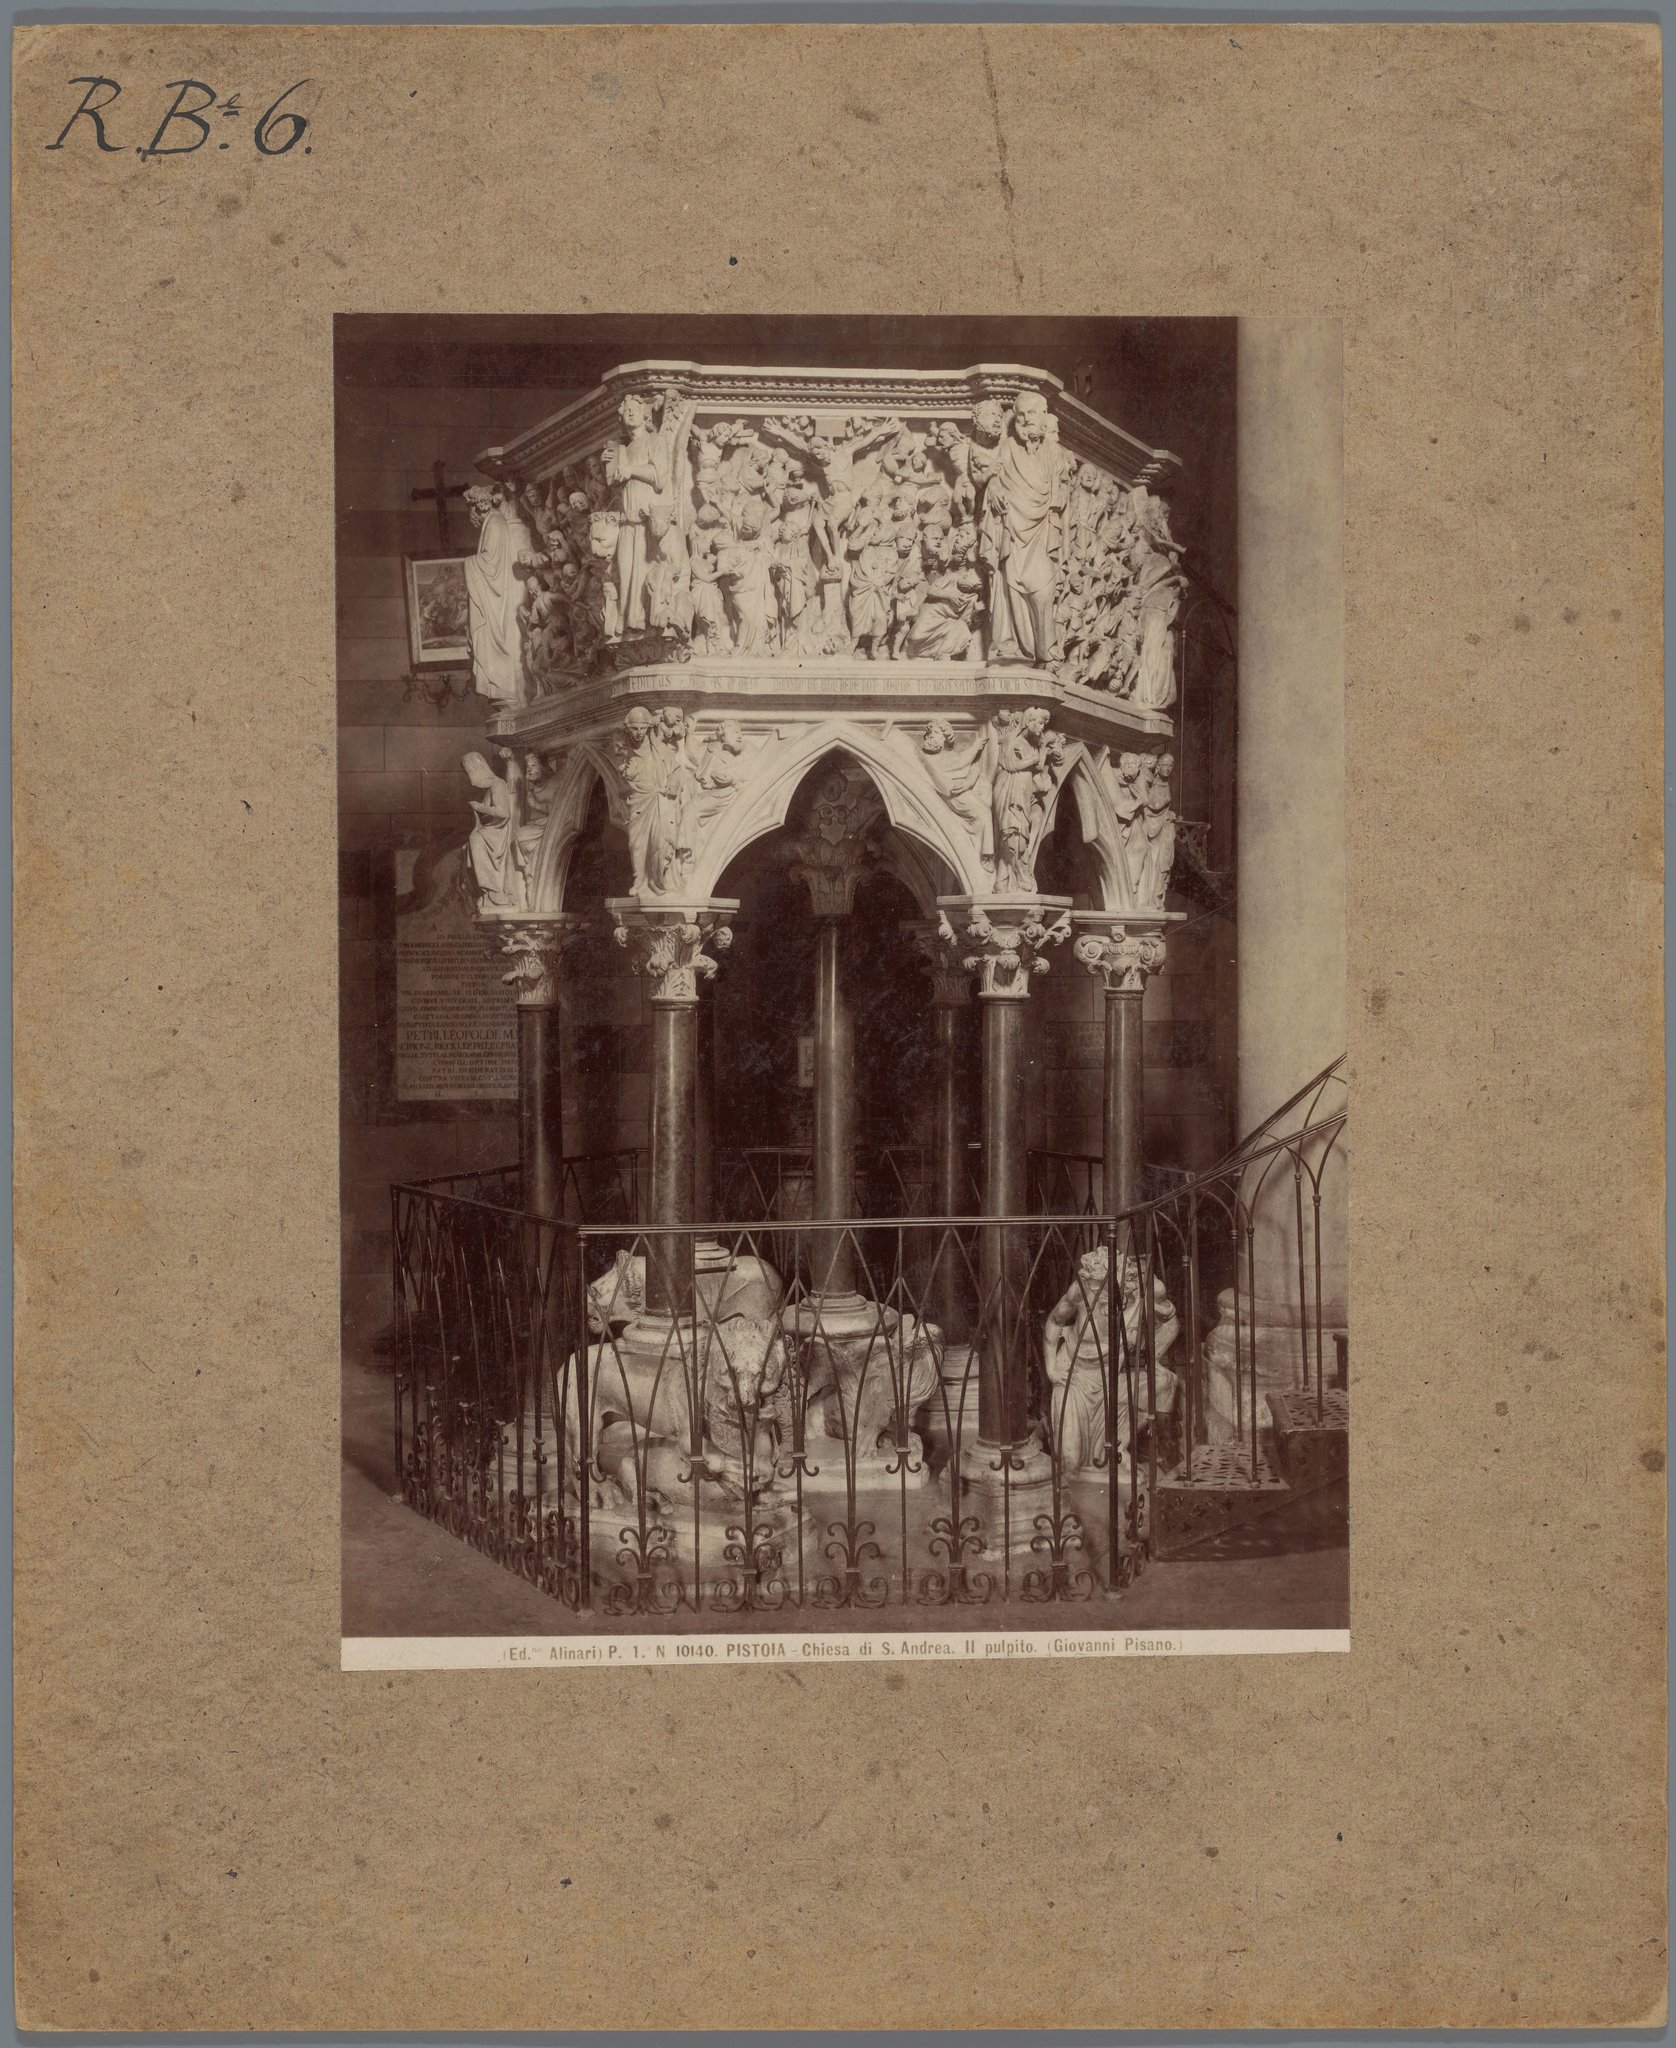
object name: photograph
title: Preekstoel van de Sint-Andreaskerk te Pistoia door Giovanni Pisano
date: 1875-1900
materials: cardboard, photographic support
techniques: albumen print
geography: pistoia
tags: pulpit, ambo, chancel, sculpture (+ relief ~ sculpture)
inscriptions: annotation, inscription: ‘R.B-. 6.’, collector's mark: Lugt 3937, number: ‘P.e 1.a N.o 10140.’